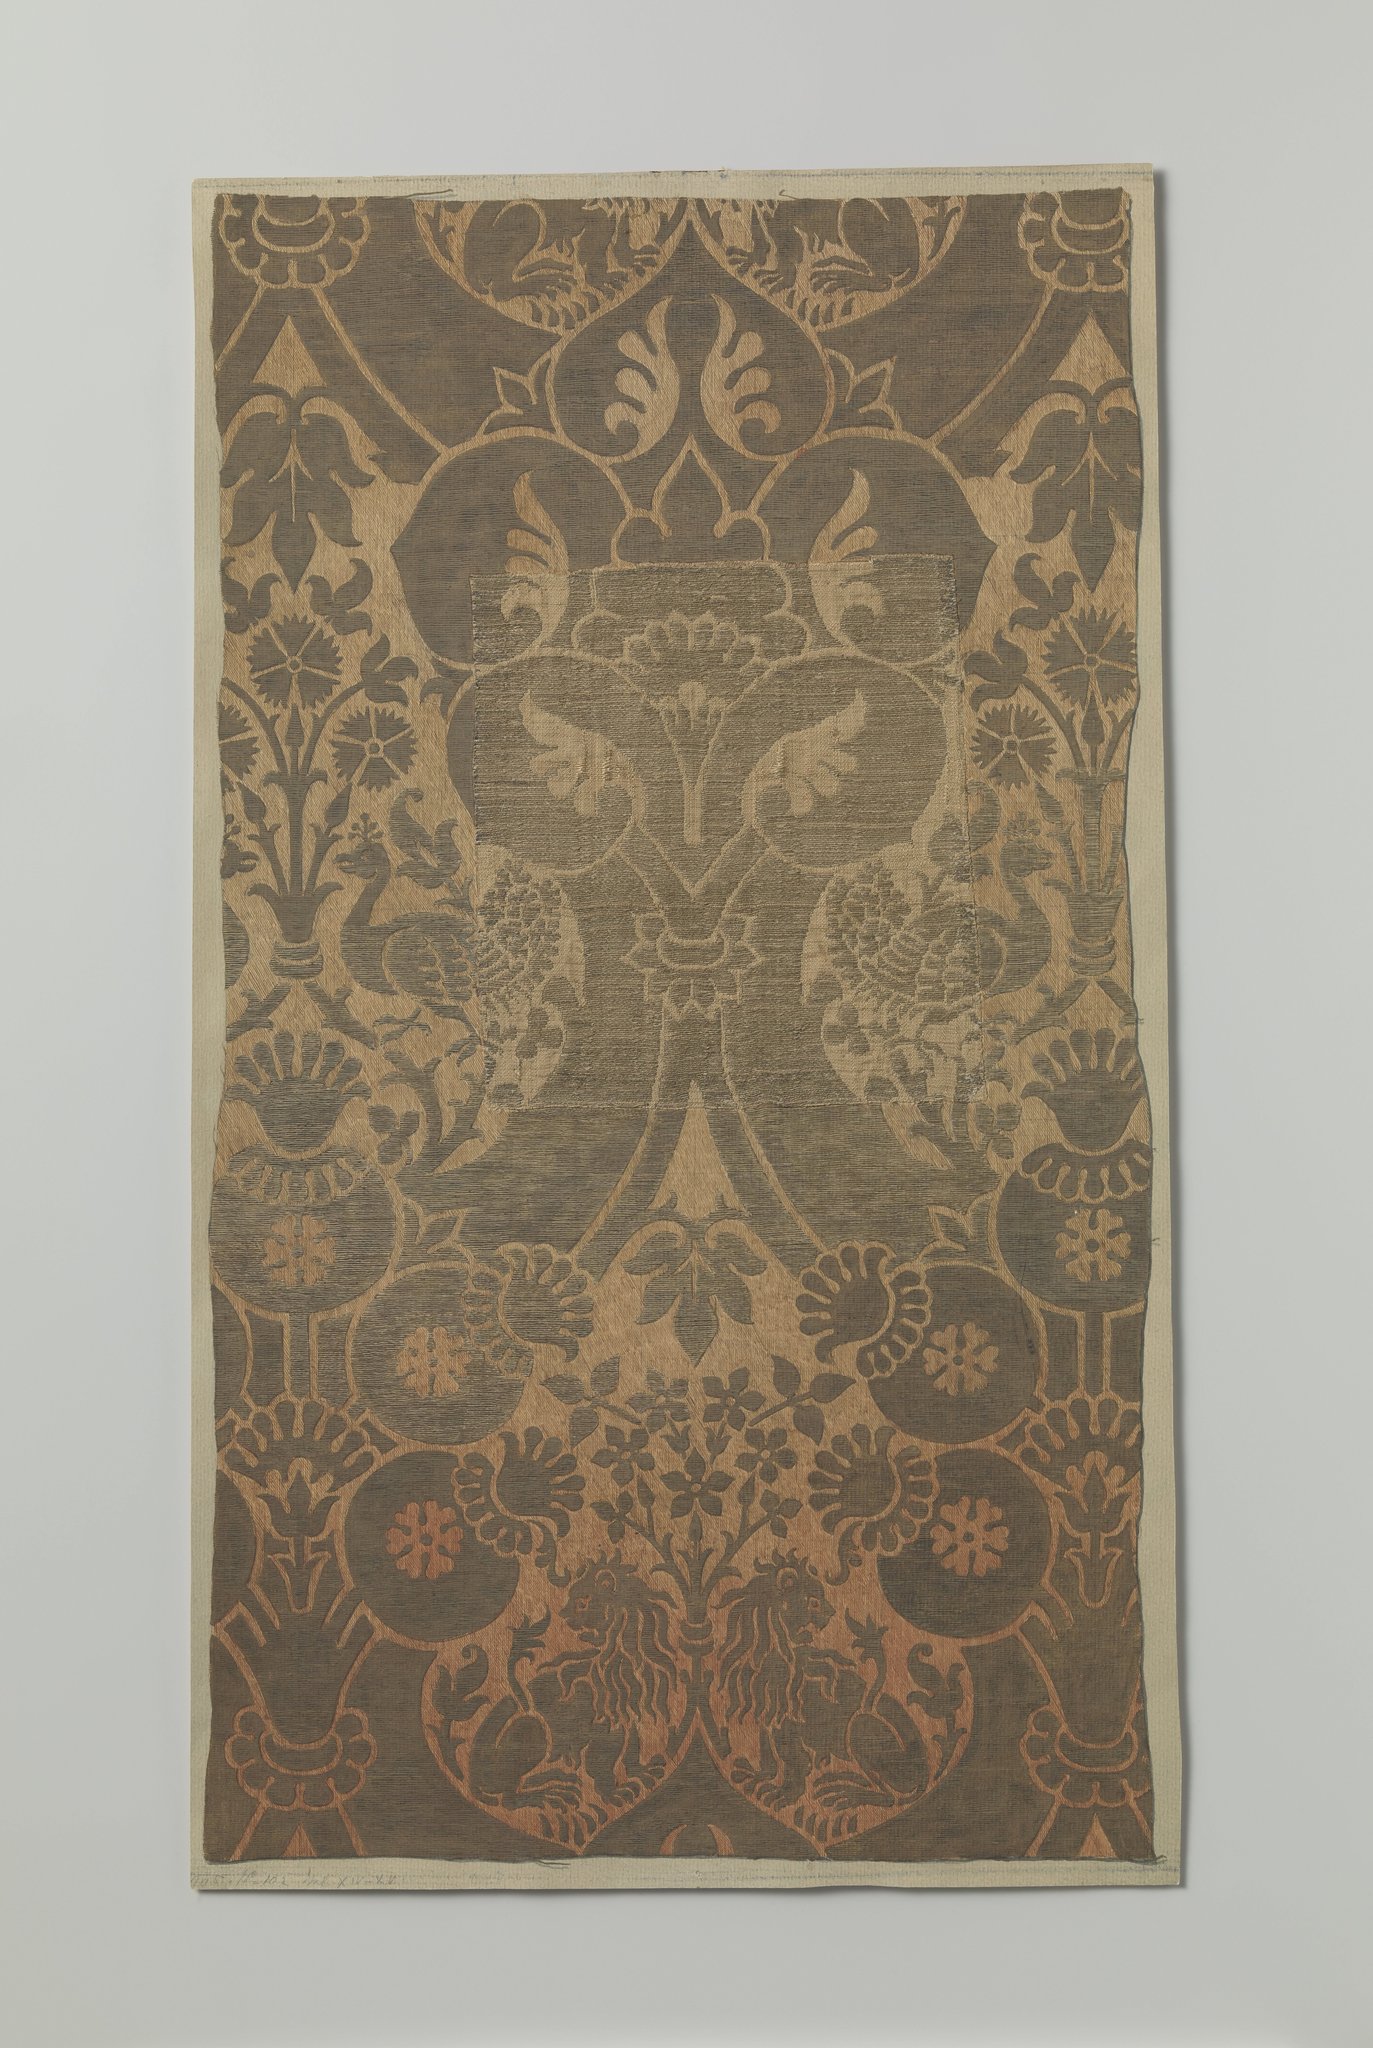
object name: fragment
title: Fragment zijdeweefsel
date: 1300-1450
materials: silk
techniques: samite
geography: italy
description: Fragment geplaatst in aanzienlijk bijgetekend deel met een totaal patroon op goudgele grond van granaatappels die spitsovale velden vormen waarbinnen beurtelings afgewende leeuwen en toegewende pauwen.